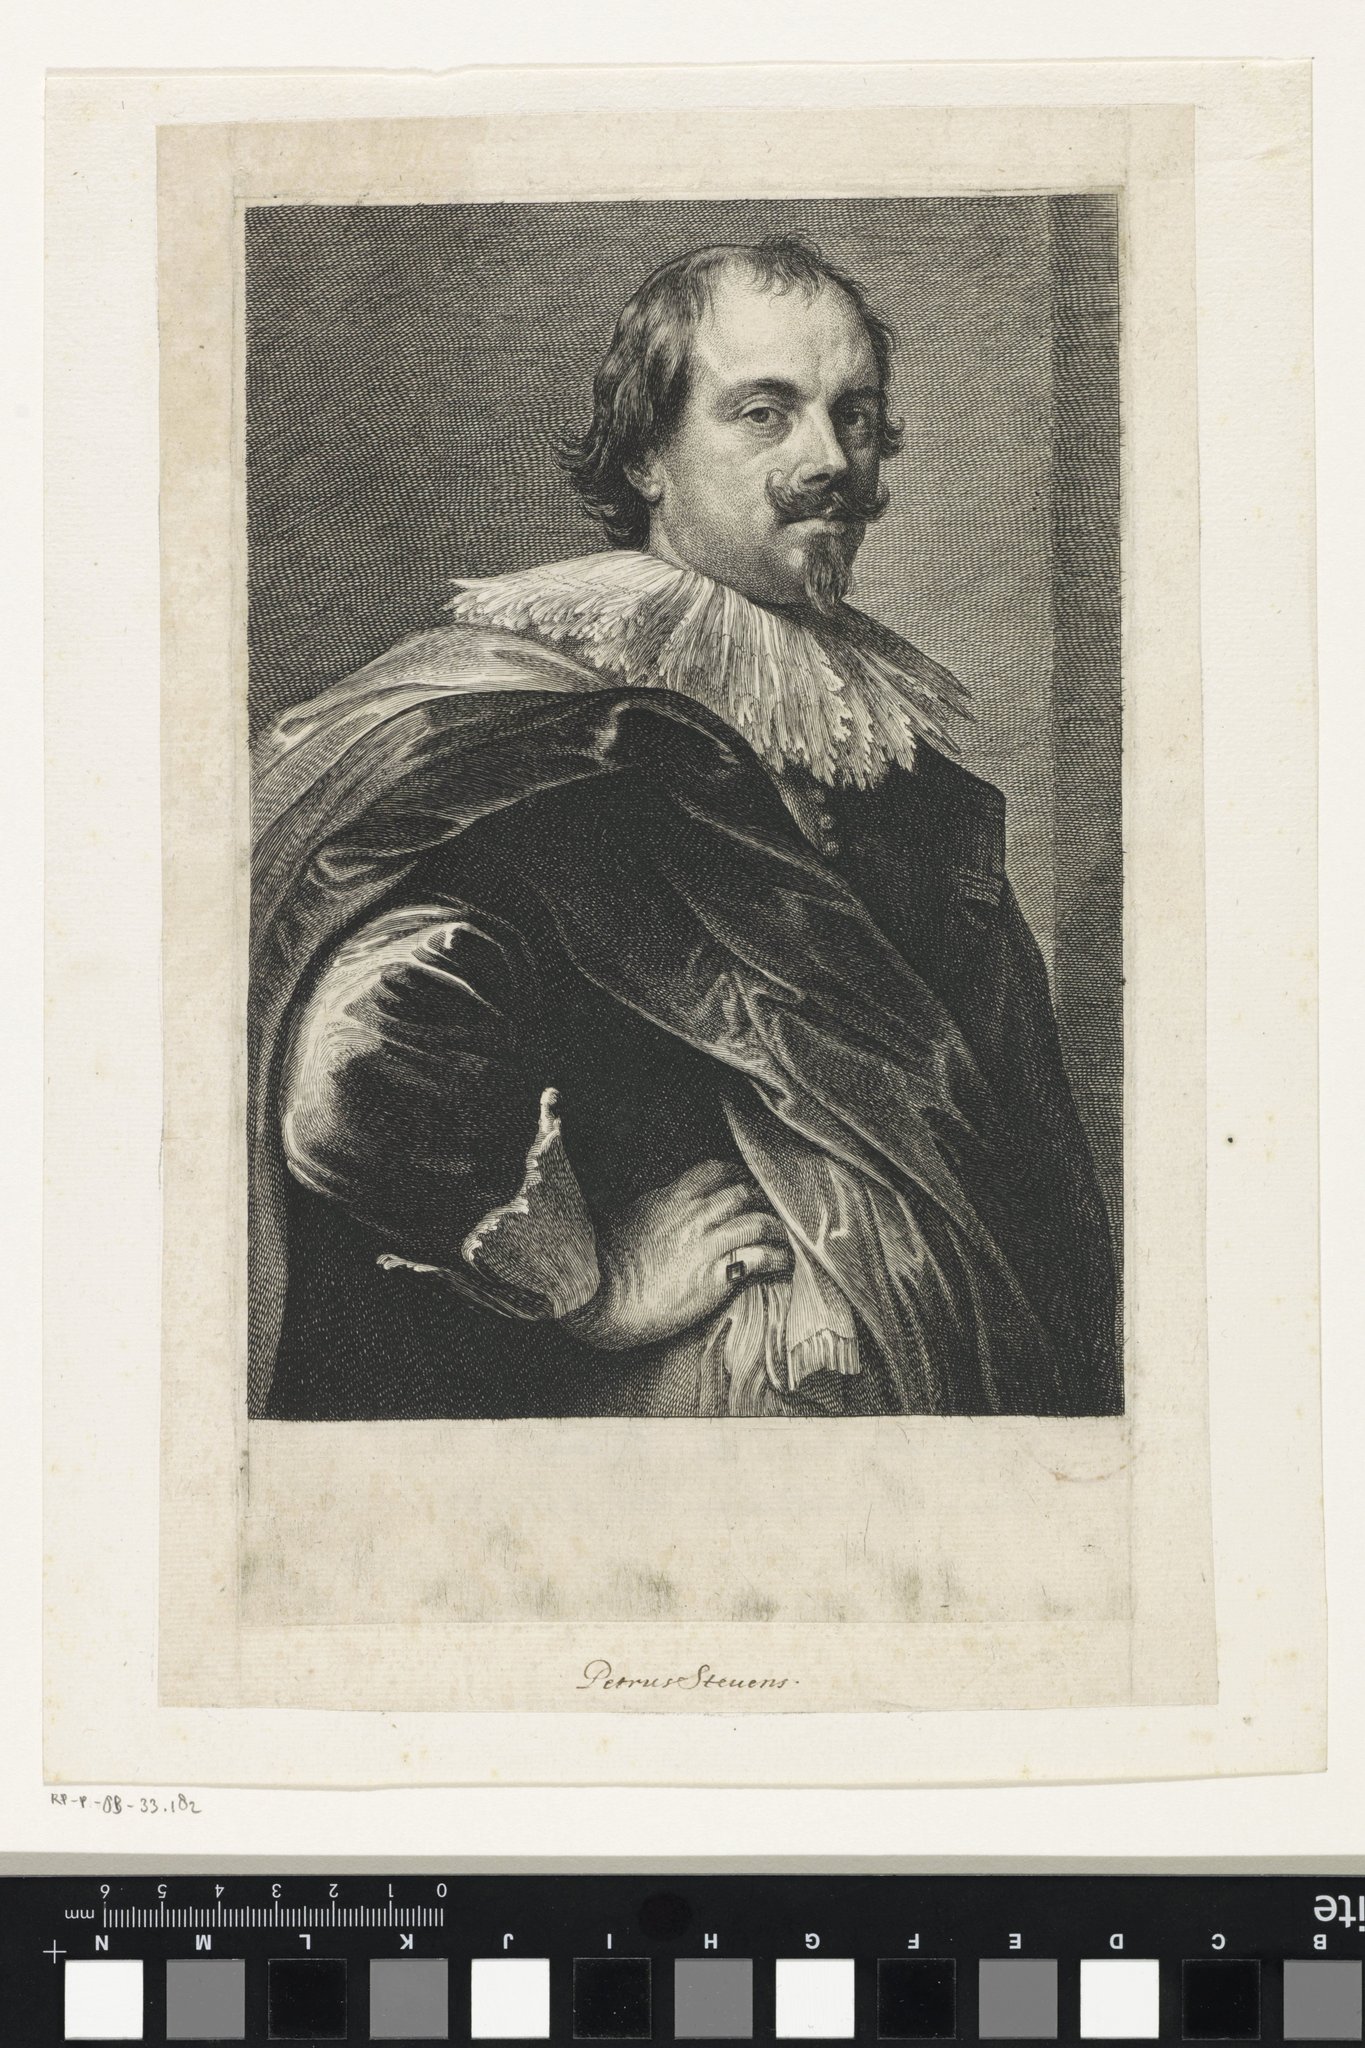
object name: print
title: Portret van Peeter Stevens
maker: lucas vorsterman (i)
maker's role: print maker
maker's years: 1595-1675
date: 1630-1646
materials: paper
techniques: engraving, etching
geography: antwerp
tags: verzamelaar, handelaar, peeter stevens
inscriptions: collector's mark: Lugt 240, name: ‘Petrus Stevens’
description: Prent gebruikt voor: Icones principum, virorum doctorum, pictorum, chalcographorum, statuariorum nec non amatorum pictoriae artis numero centum ab Ant. van Dyck ad vivum expressae ejusque sumptibus aeri incisae. Antwerpen: Gillis Hendricx, [1645-1646].